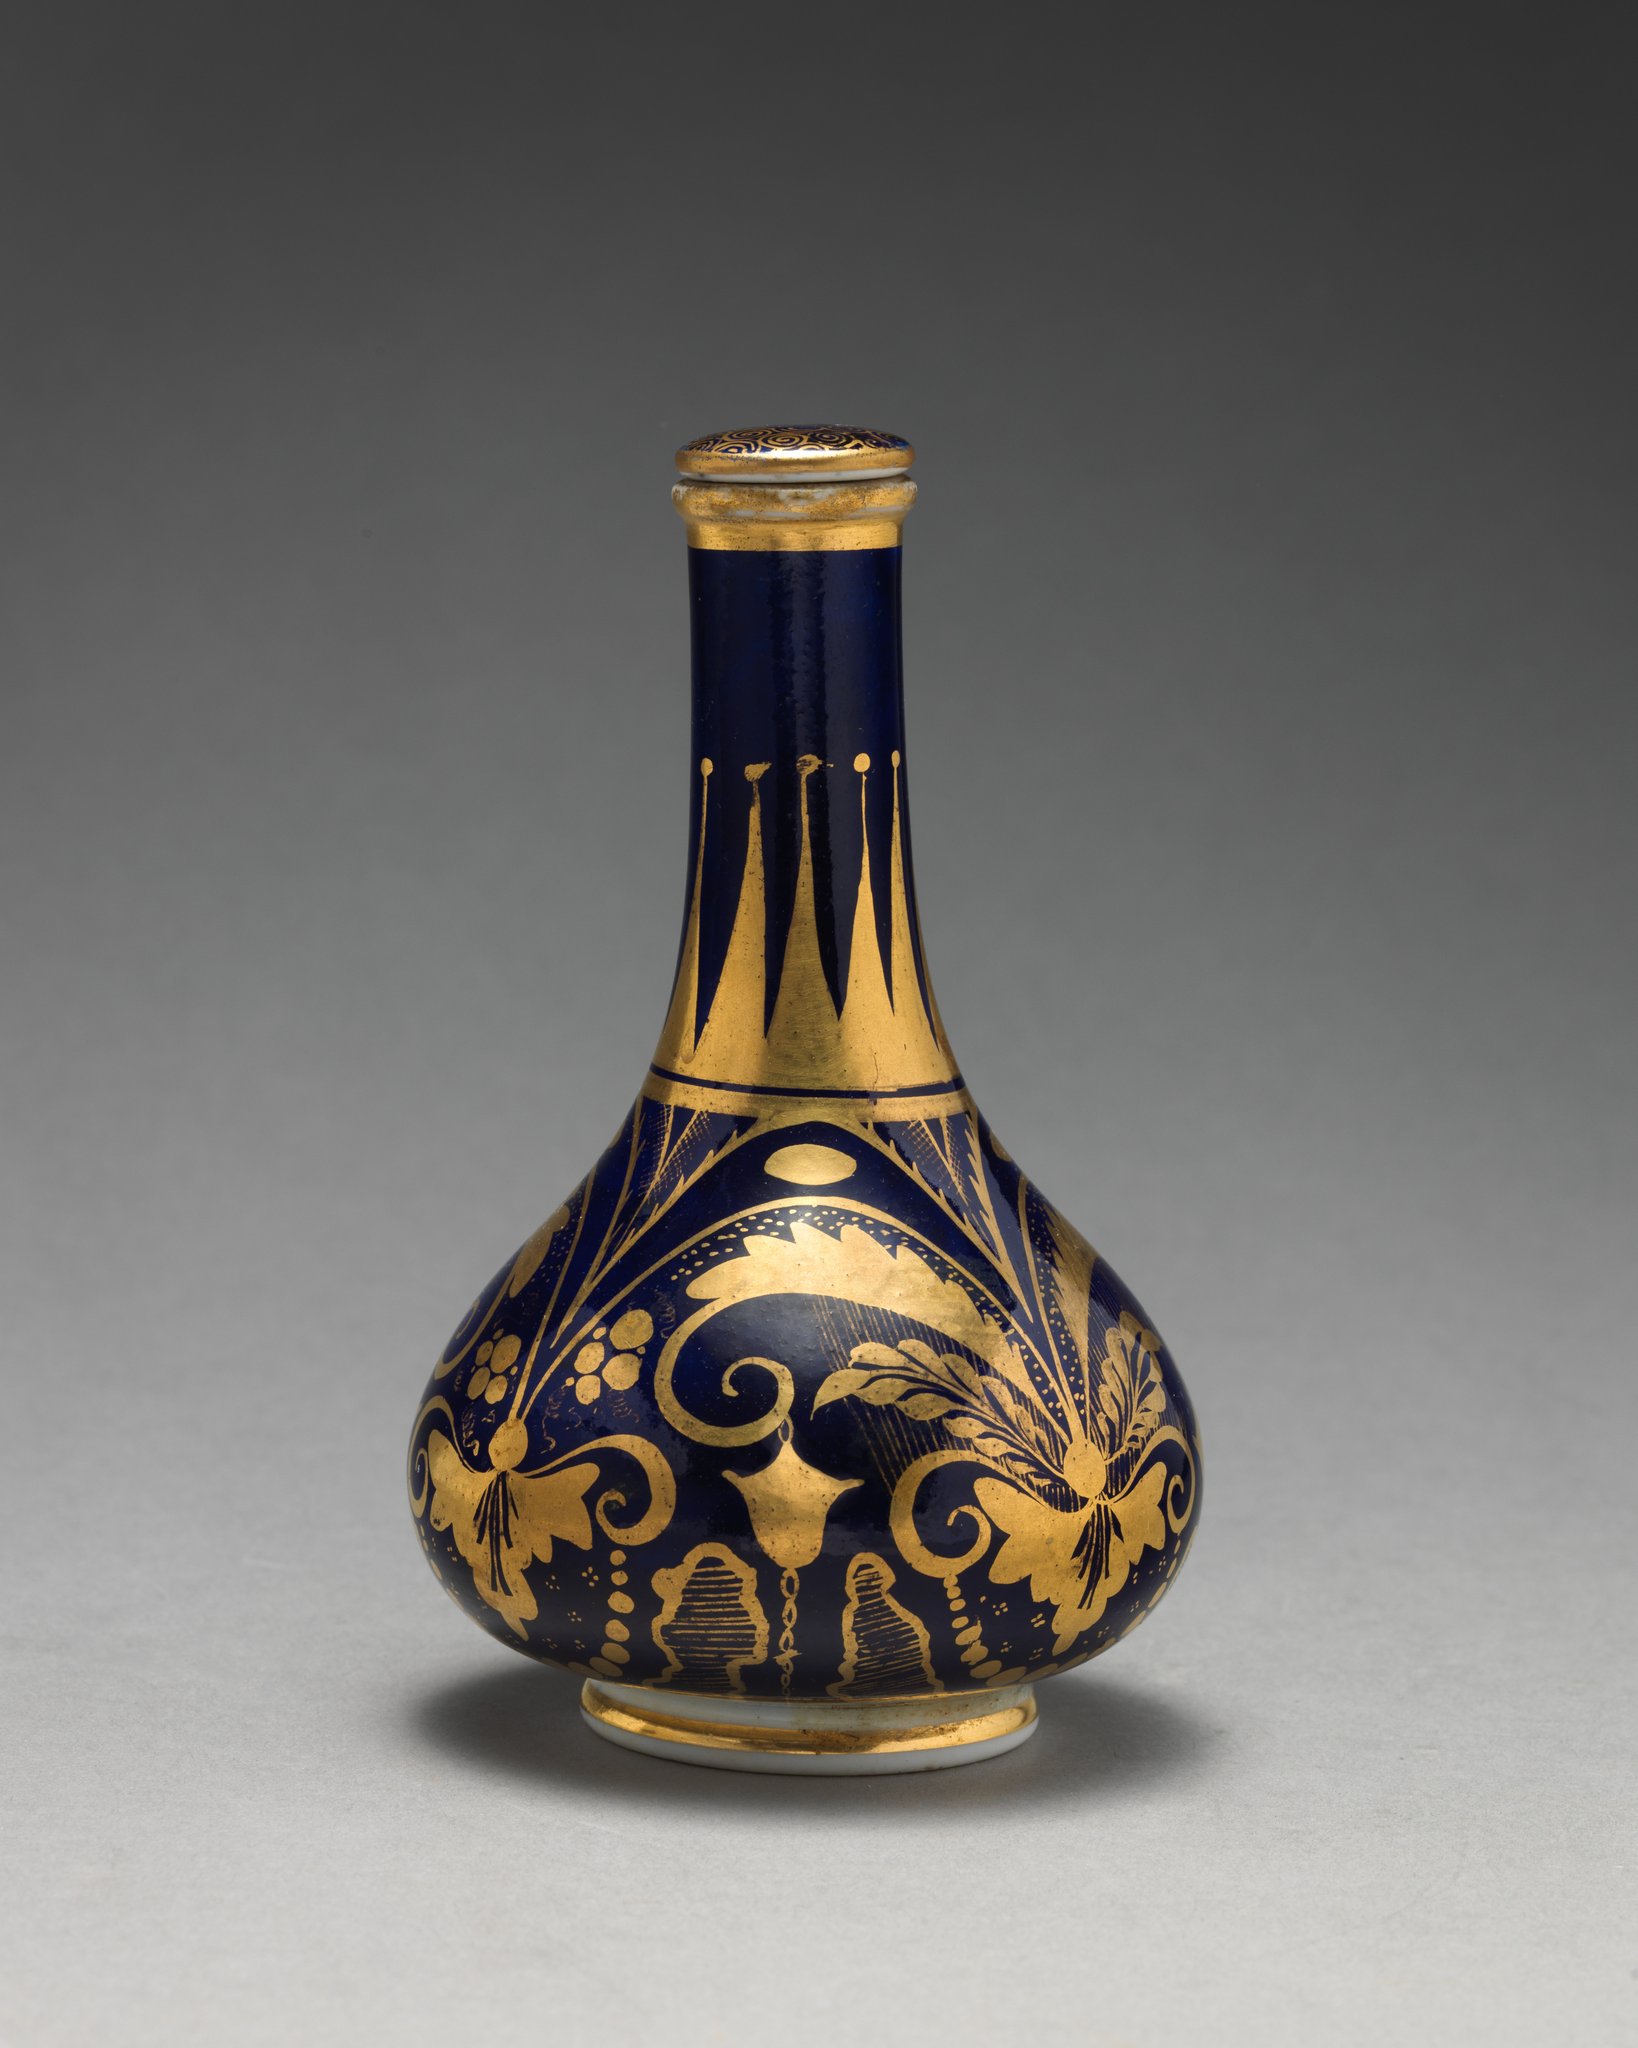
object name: bottle vase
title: Bottle vase with stopper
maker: crown derby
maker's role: maker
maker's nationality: british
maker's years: 1750-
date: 1862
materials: bone china, enamel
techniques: gilding